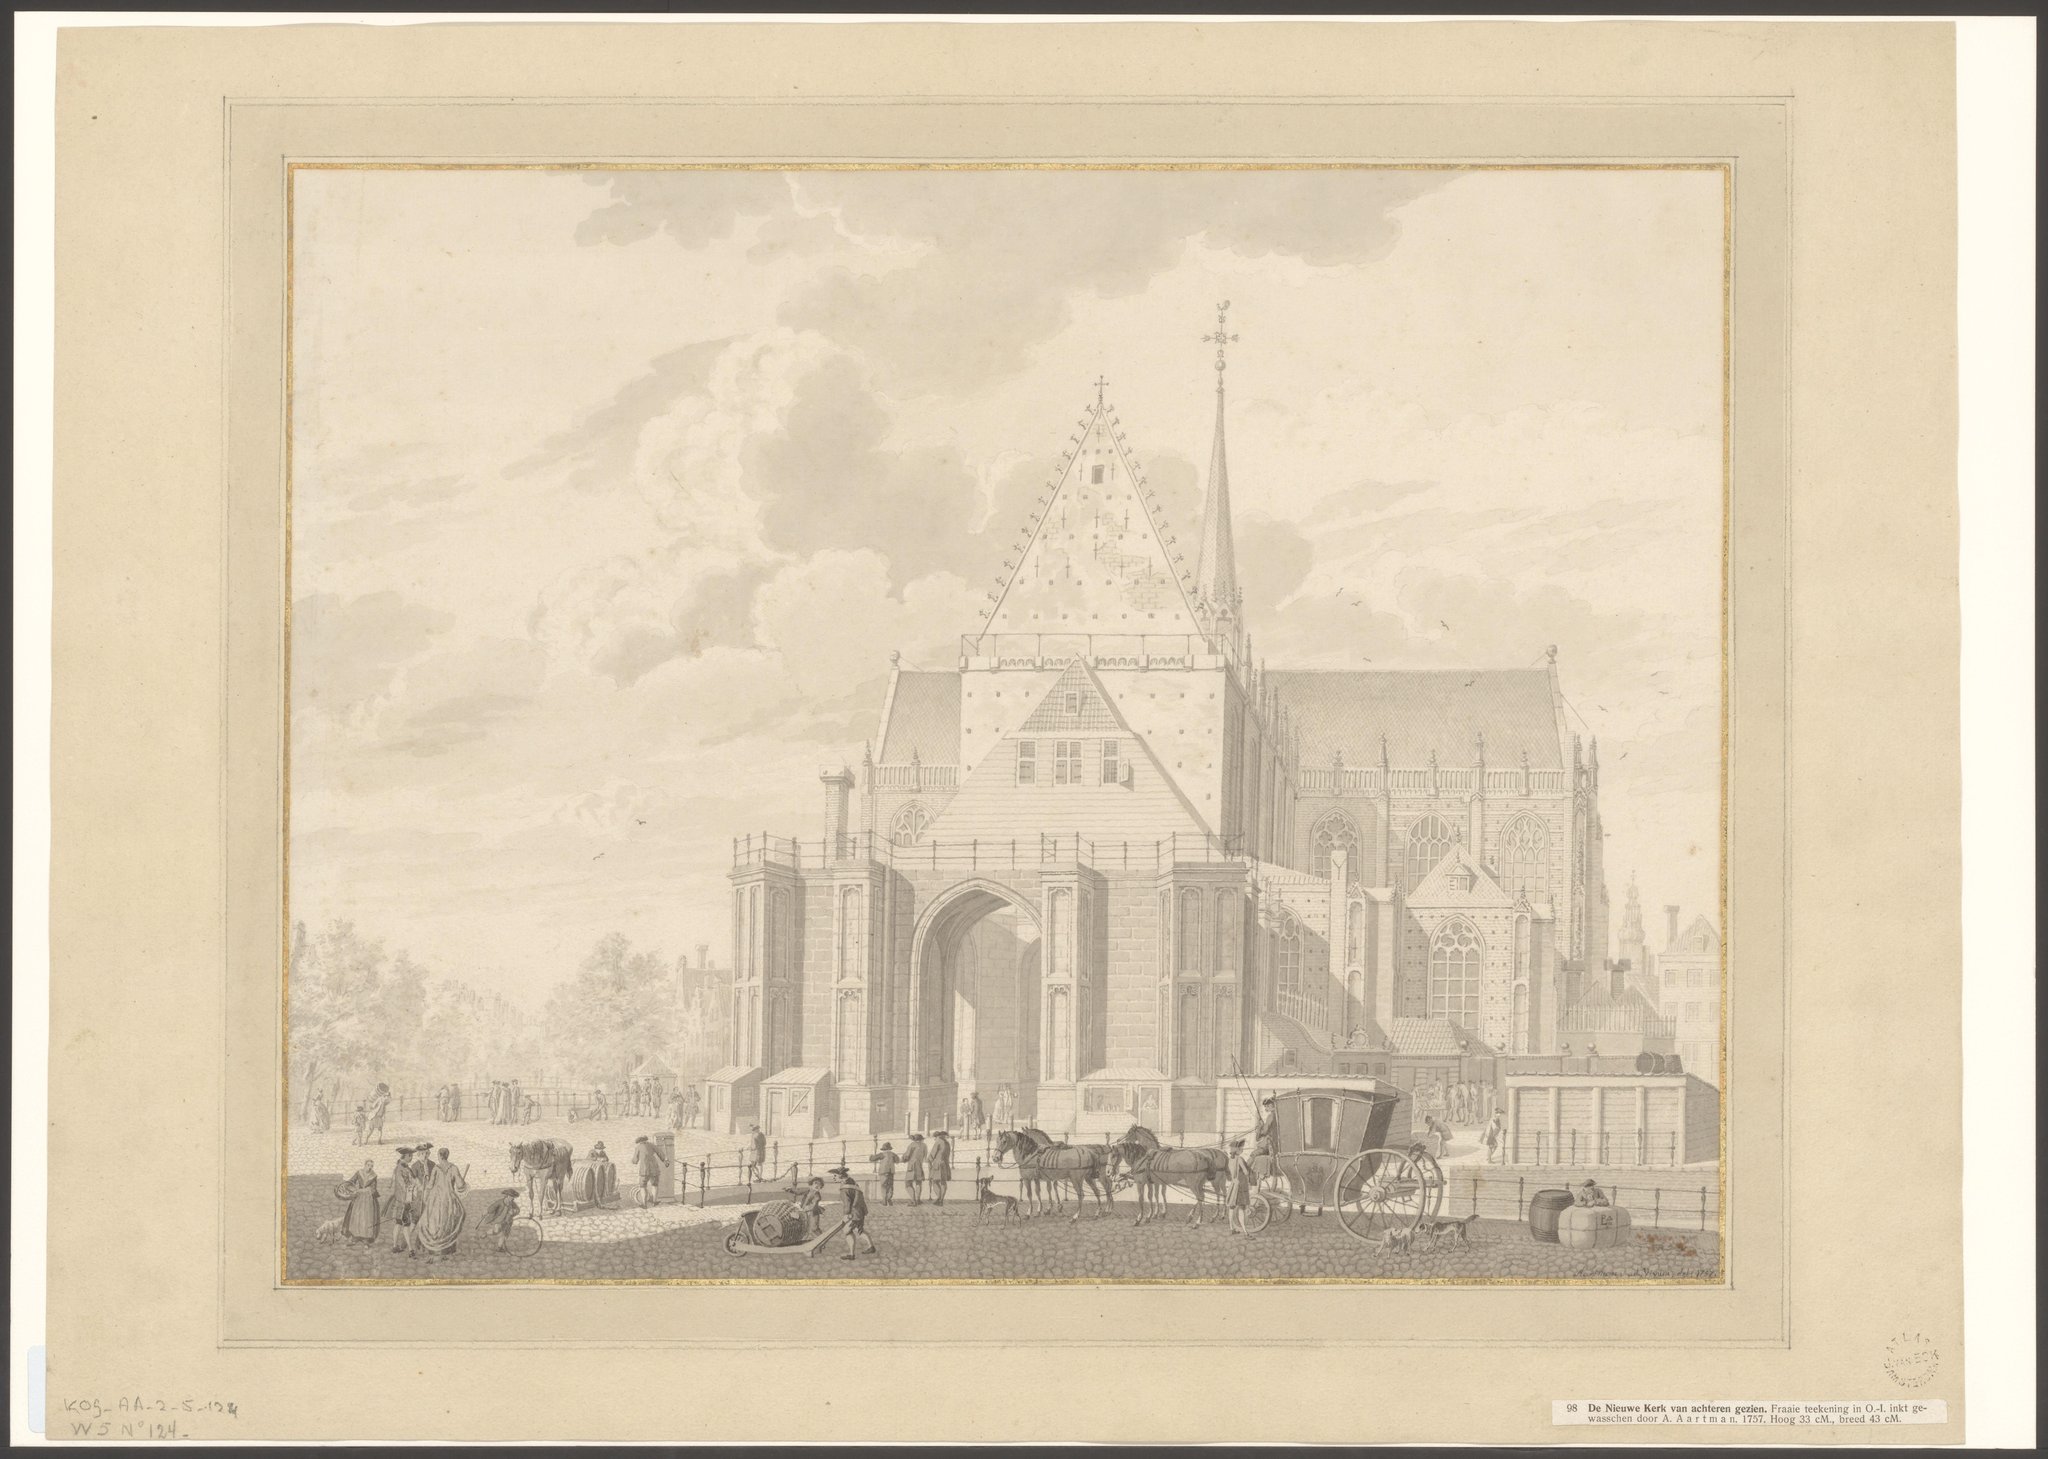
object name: drawing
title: Gezicht op de Nieuwe Kerk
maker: nicolaes aartman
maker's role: draughtsman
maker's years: 1713-1760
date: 1757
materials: paint, ink, paper, pencil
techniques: brush, pen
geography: amsterdam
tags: church (exterior), parts of church exterior and annexes: façade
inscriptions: : ‘98 De Nieuwe (...) breed 43 cM.’, signature and date: ‘Aartman: ad: vivum: del: 1757.’, inscription: ‘de Onvolmaakte Toren [...] Nieuwe Kerk’, collector's mark: Lugt 800a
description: Tekening binnen de Atlas Van Eck ingedeeld op wijknummer 5.